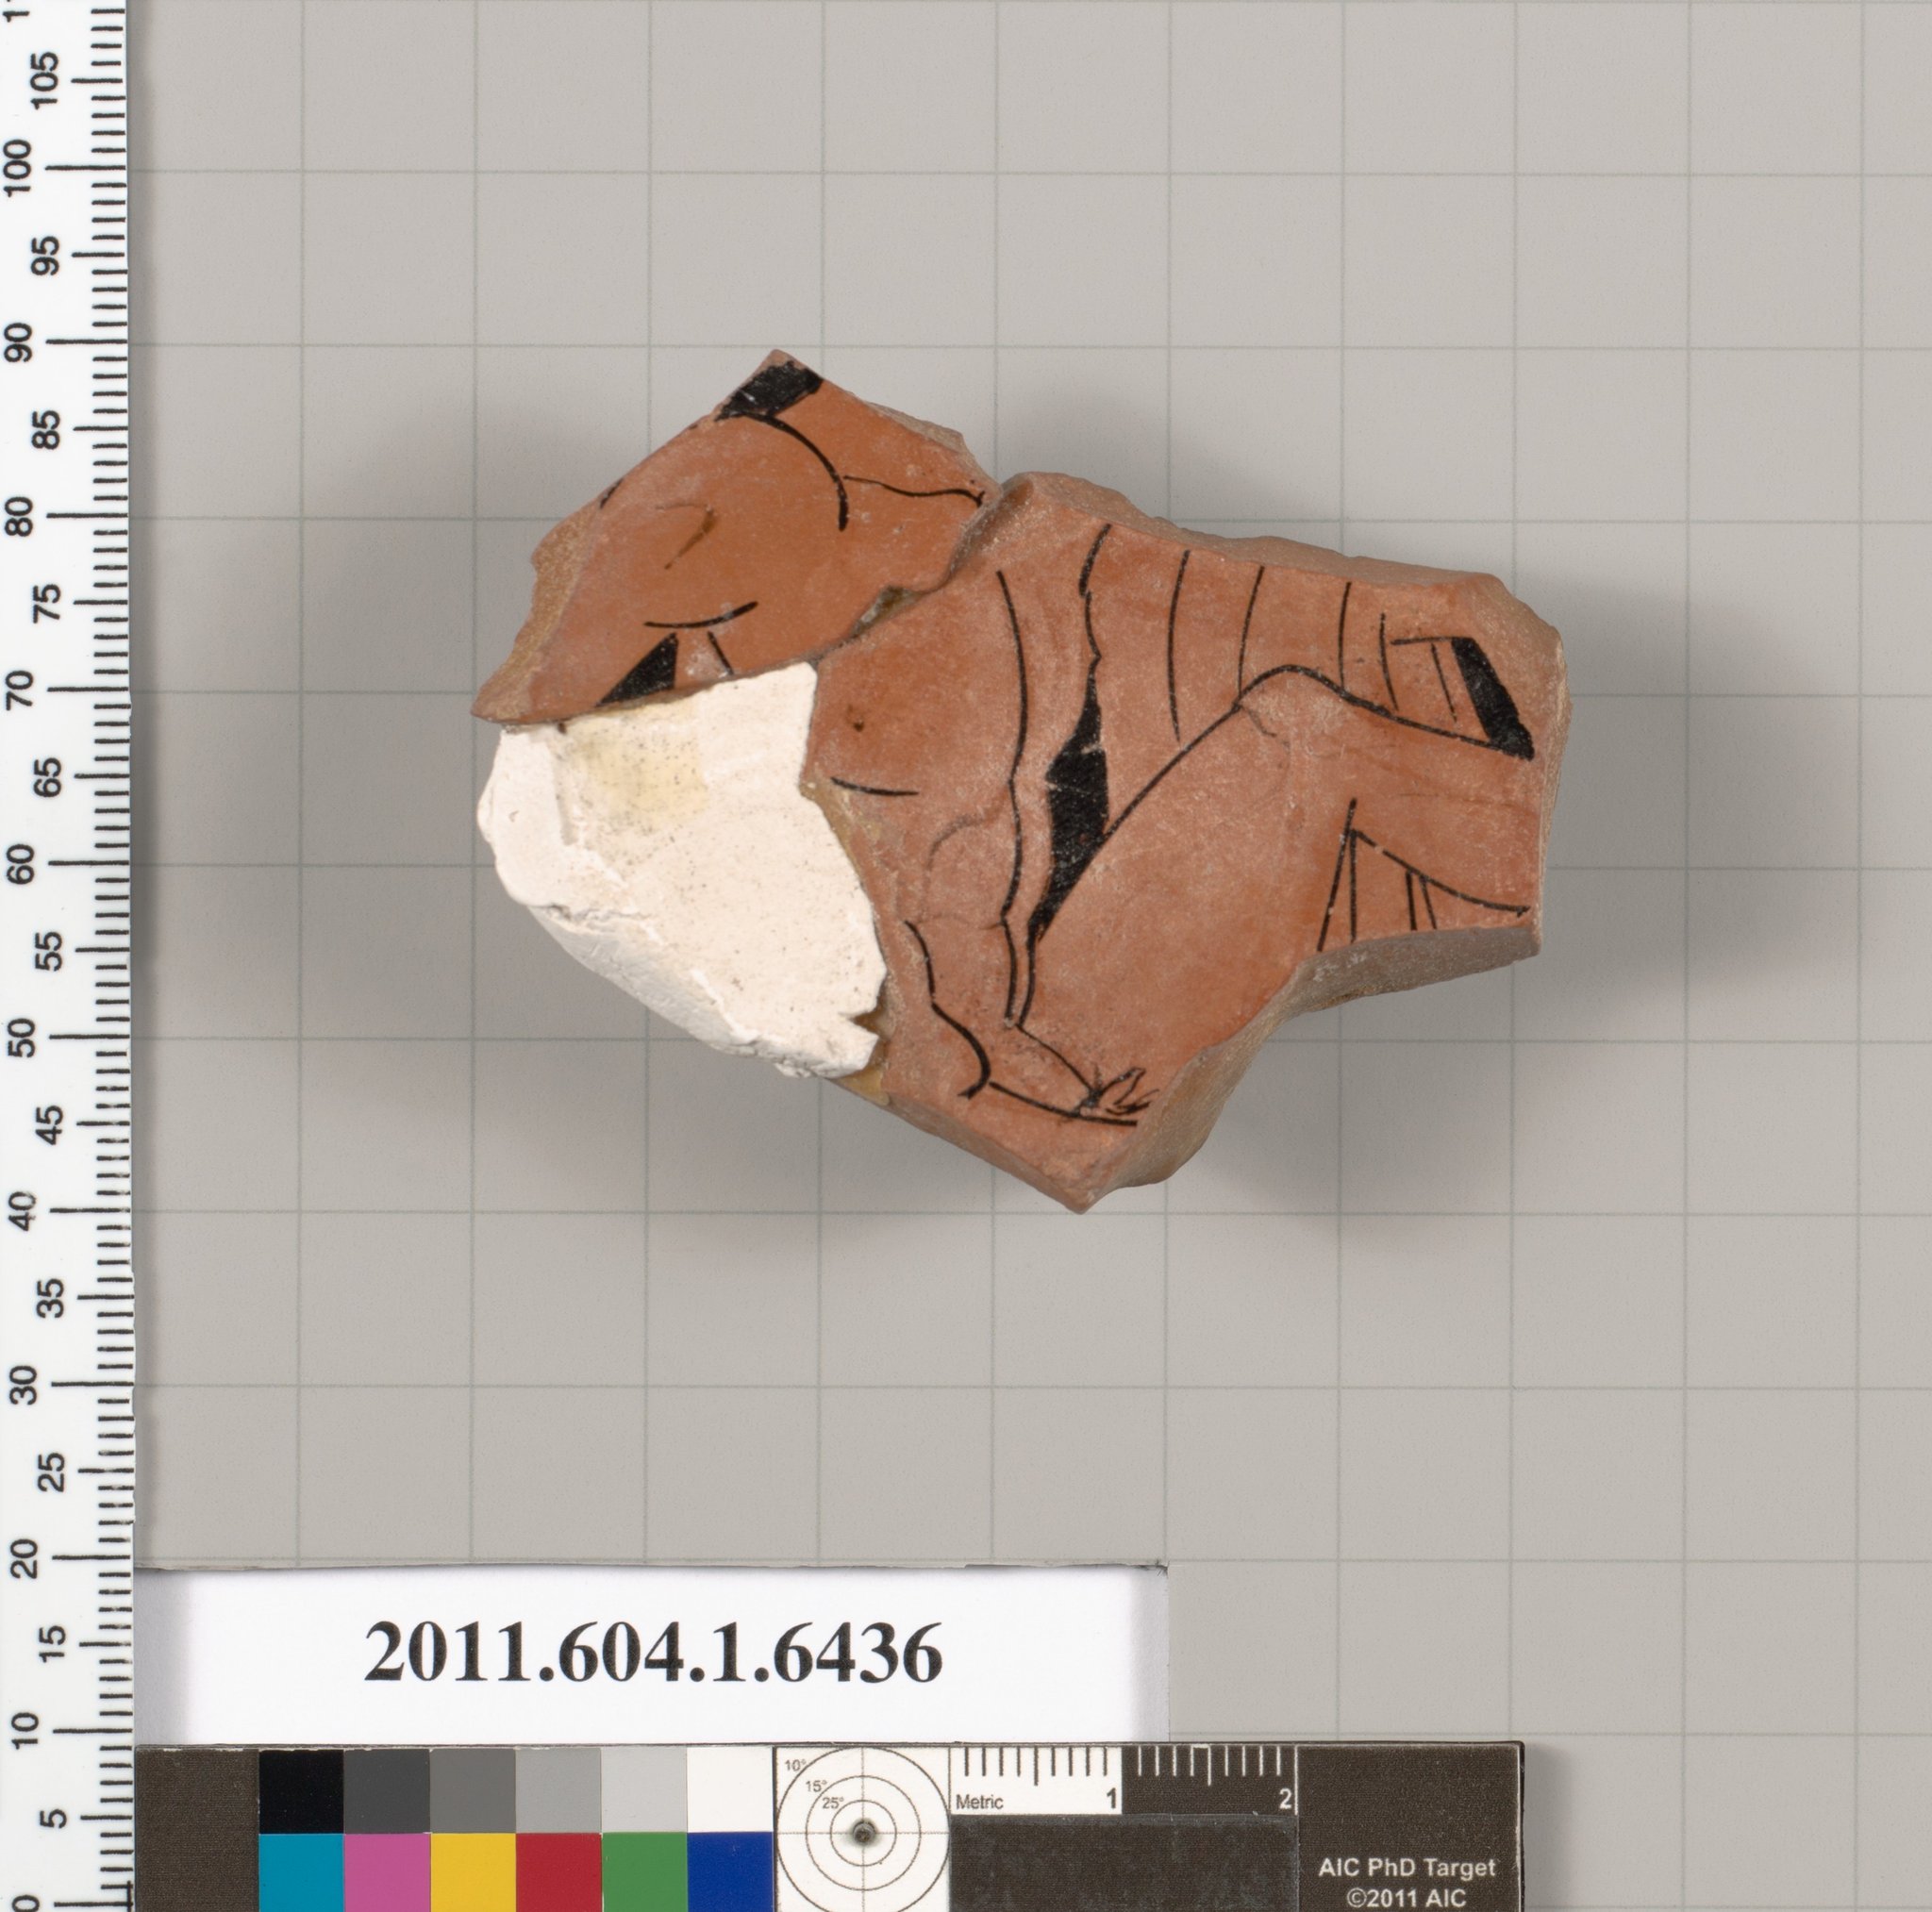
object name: kylix fragment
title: Terracotta fragment of a kylix (drinking cup)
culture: greek, attic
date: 490-480 BCE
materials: terracotta